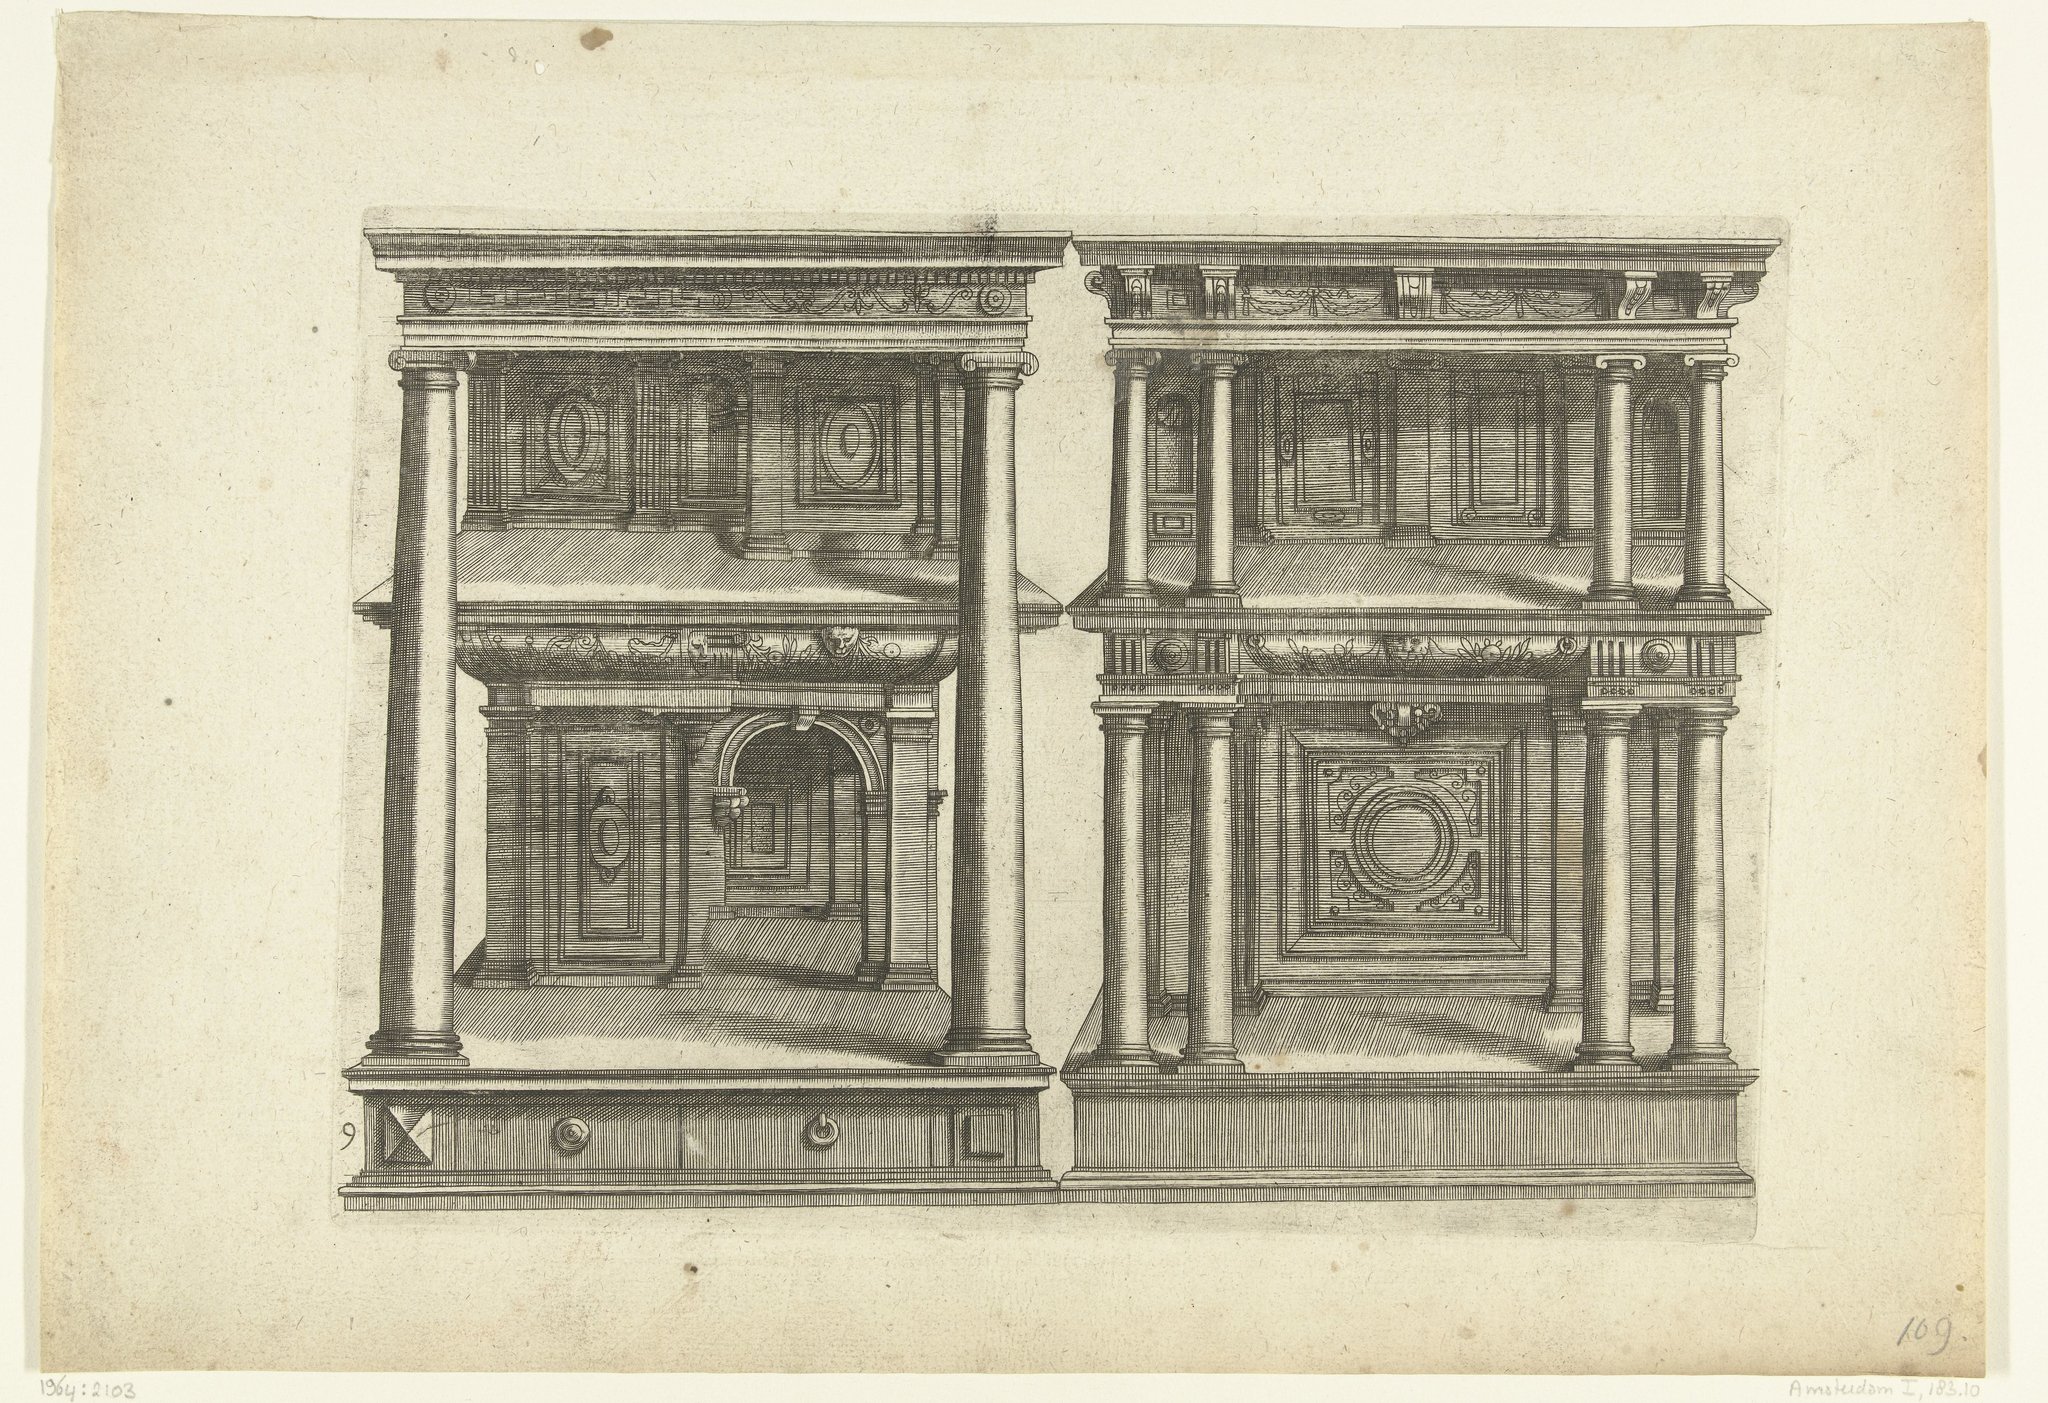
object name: ornament print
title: Differents pourtraicts de menuiseri (...)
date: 1583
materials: paper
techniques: engraving, etching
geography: netherlands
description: Het linker buffet heeft onderaan twee laden. De linker en de rechter helft van dit buffet zijn op verschillende wijze gedecoreerd. Blad 9 van 15 genummerde bladen + titelblad uit een serie van 16.